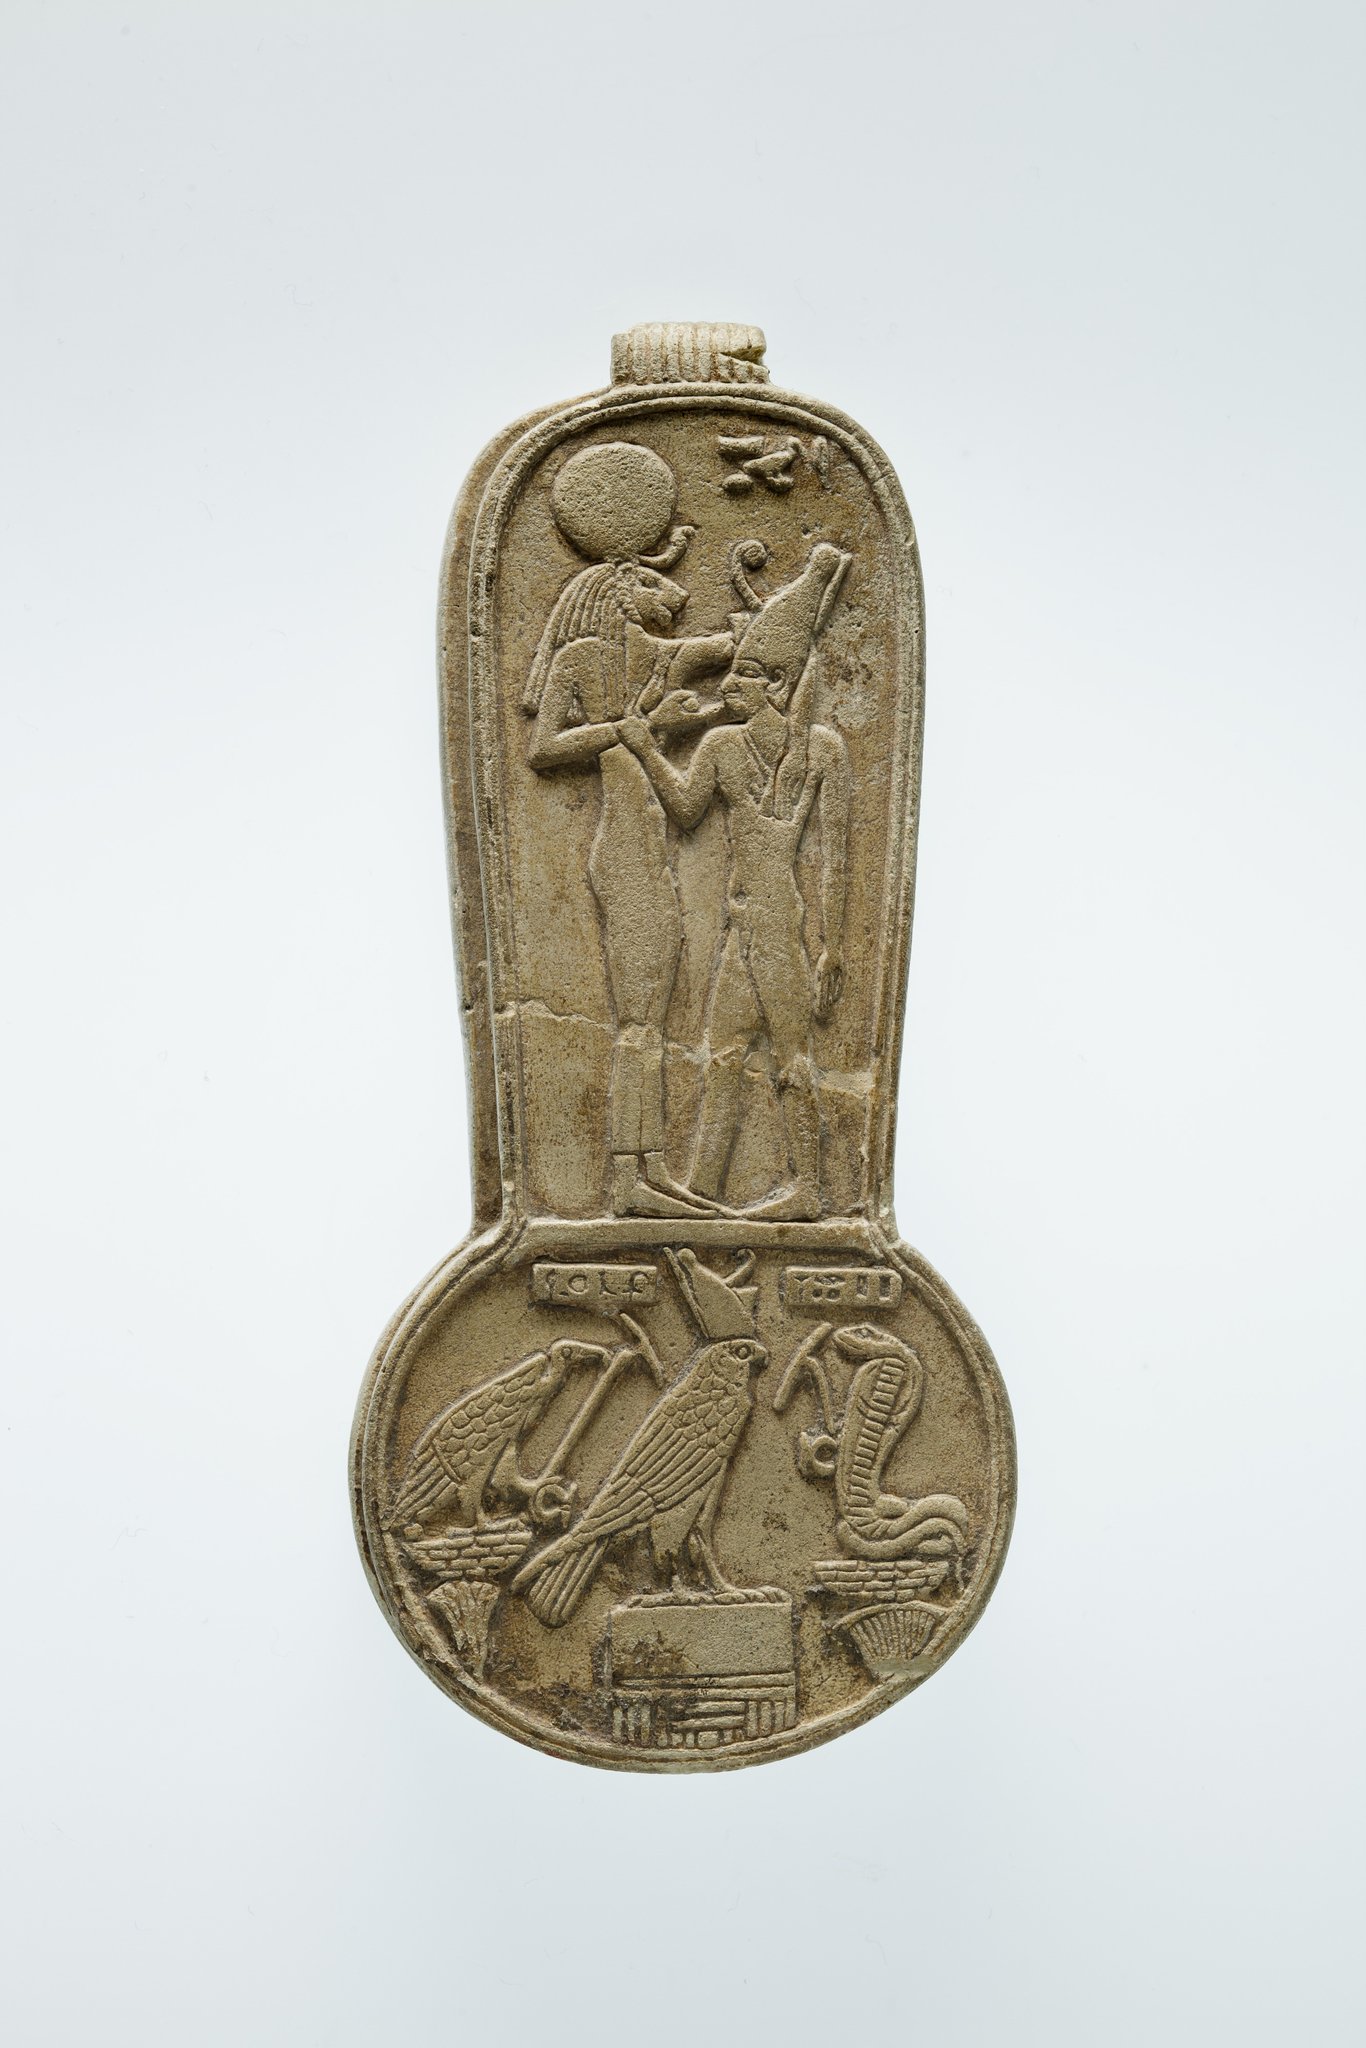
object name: menat, taharqo nursed by the lion headed goddess bastet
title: Counterweight of a menit necklace with an image of Bastet nursing King Taharqo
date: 690-664 BCE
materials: faience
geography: nubia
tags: birds,kings,sekhmet,snakes